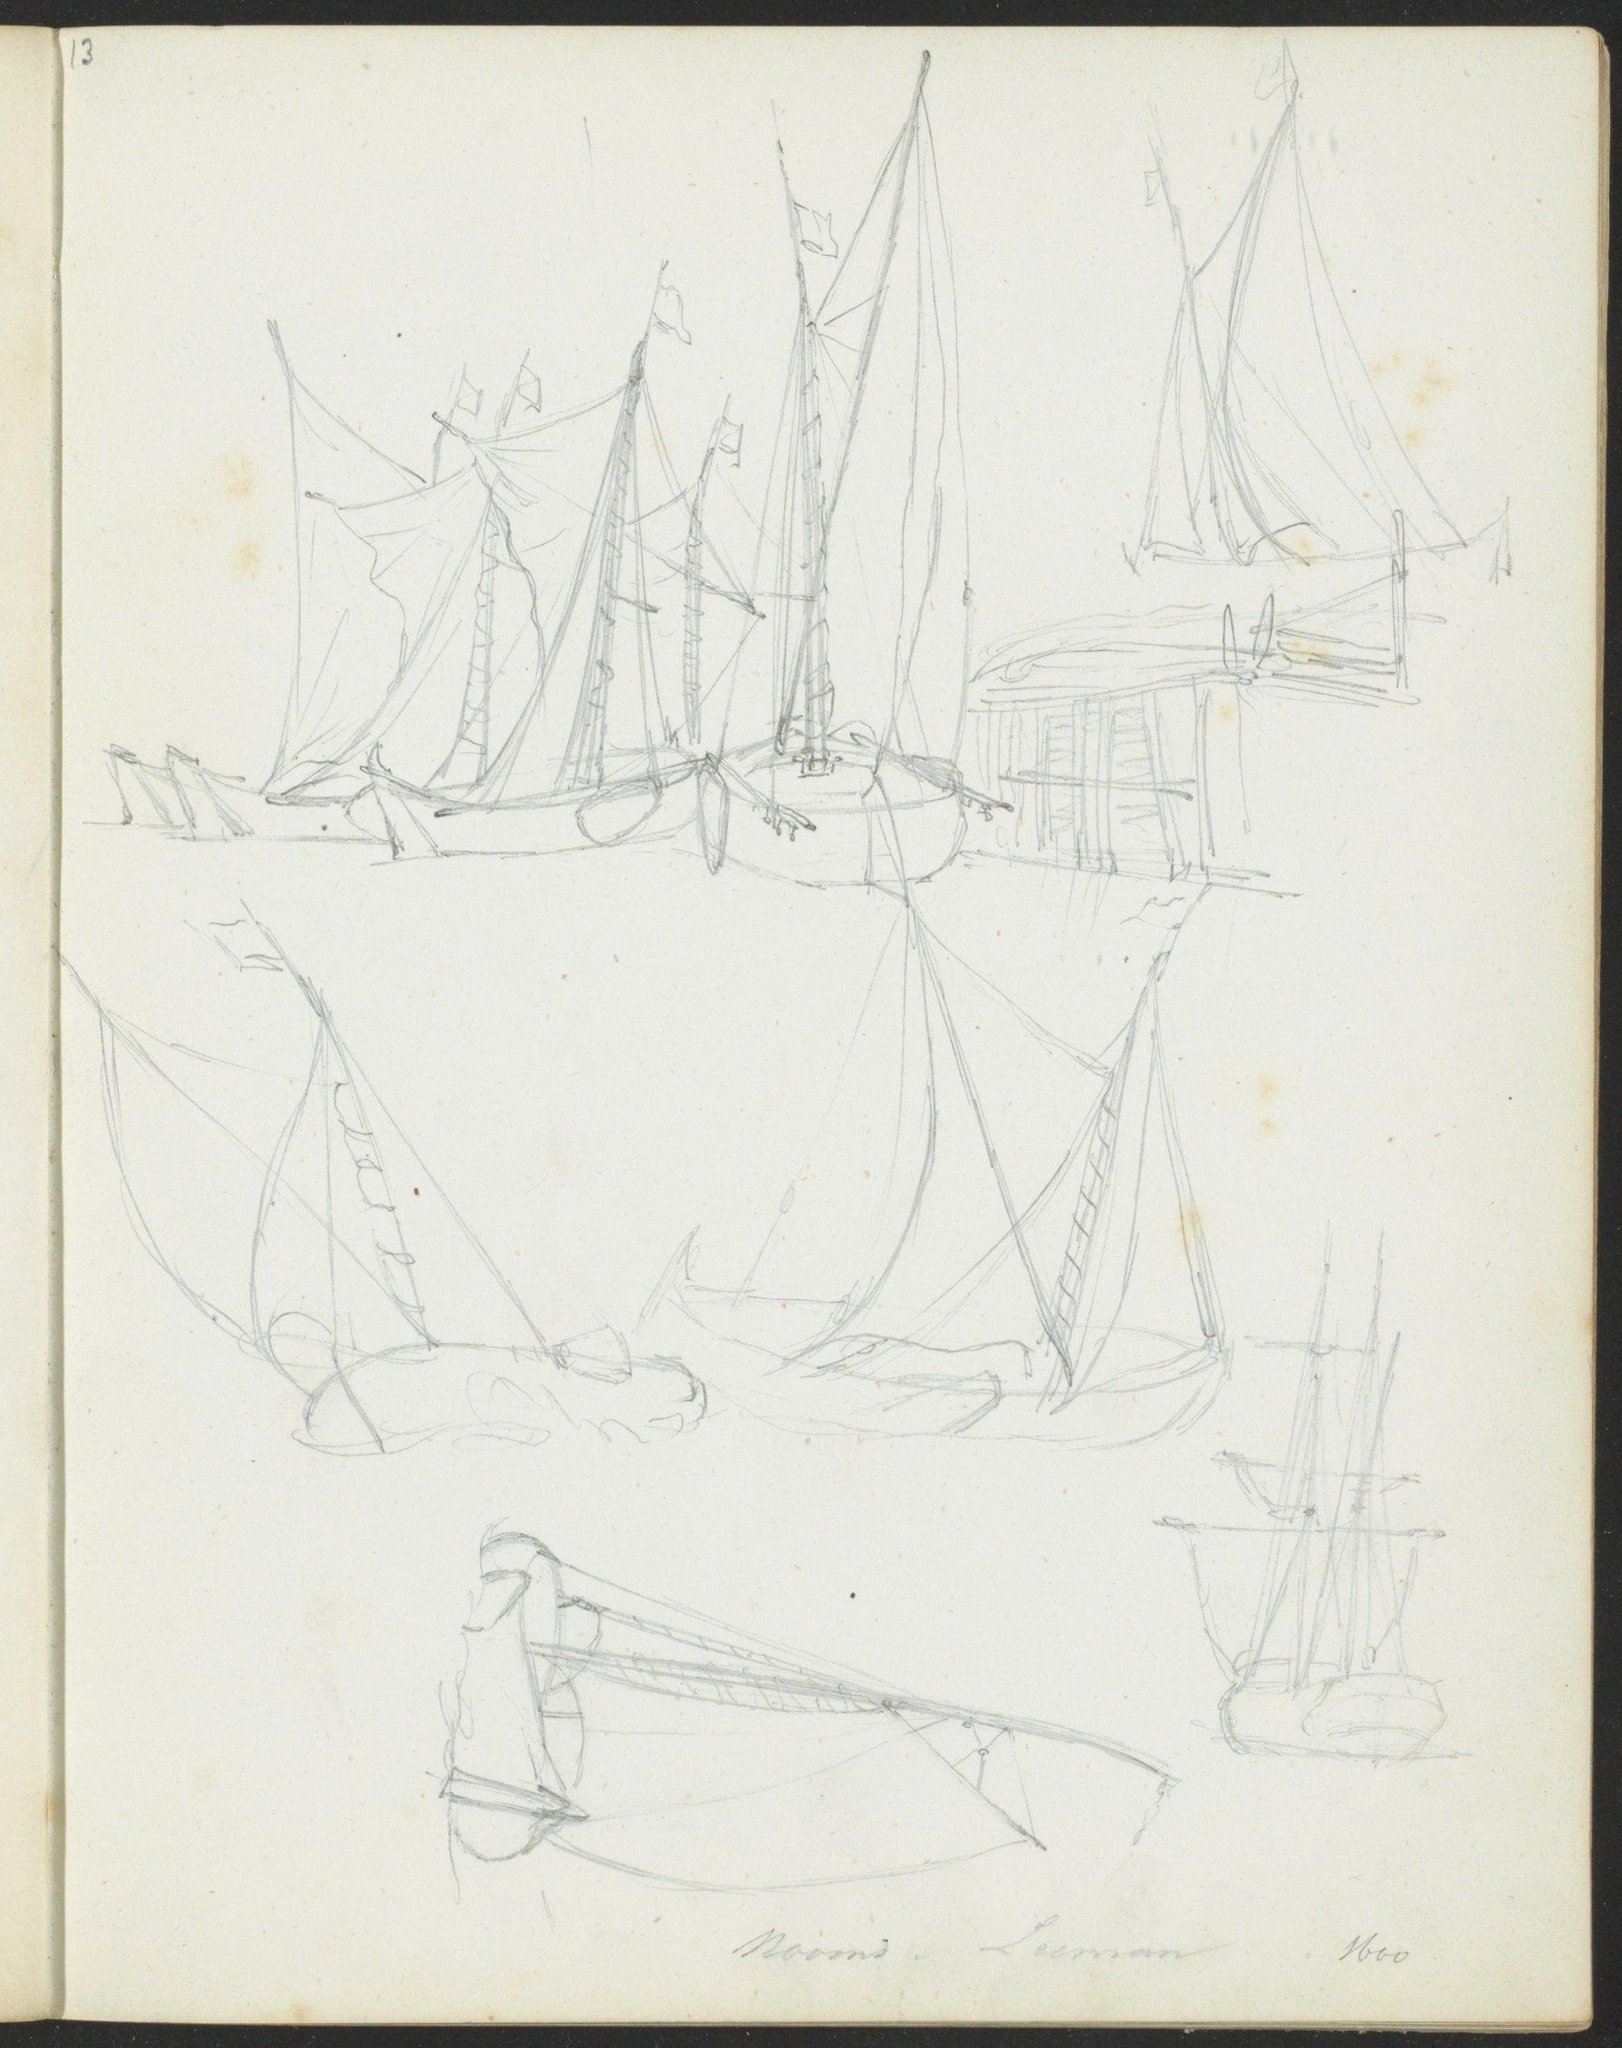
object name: sketchbook leaf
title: Studieblad met zeilschepen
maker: hendrik abraham klinkhamer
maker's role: draughtsman, painter, print maker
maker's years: 1810-1872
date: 1820-1872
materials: paper, pencil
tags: sailing-ship, sailing-boat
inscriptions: annotation: ‘Nooms Zeeman 1600’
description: Blad 13 recto uit een schetsboek met 21 bladen.